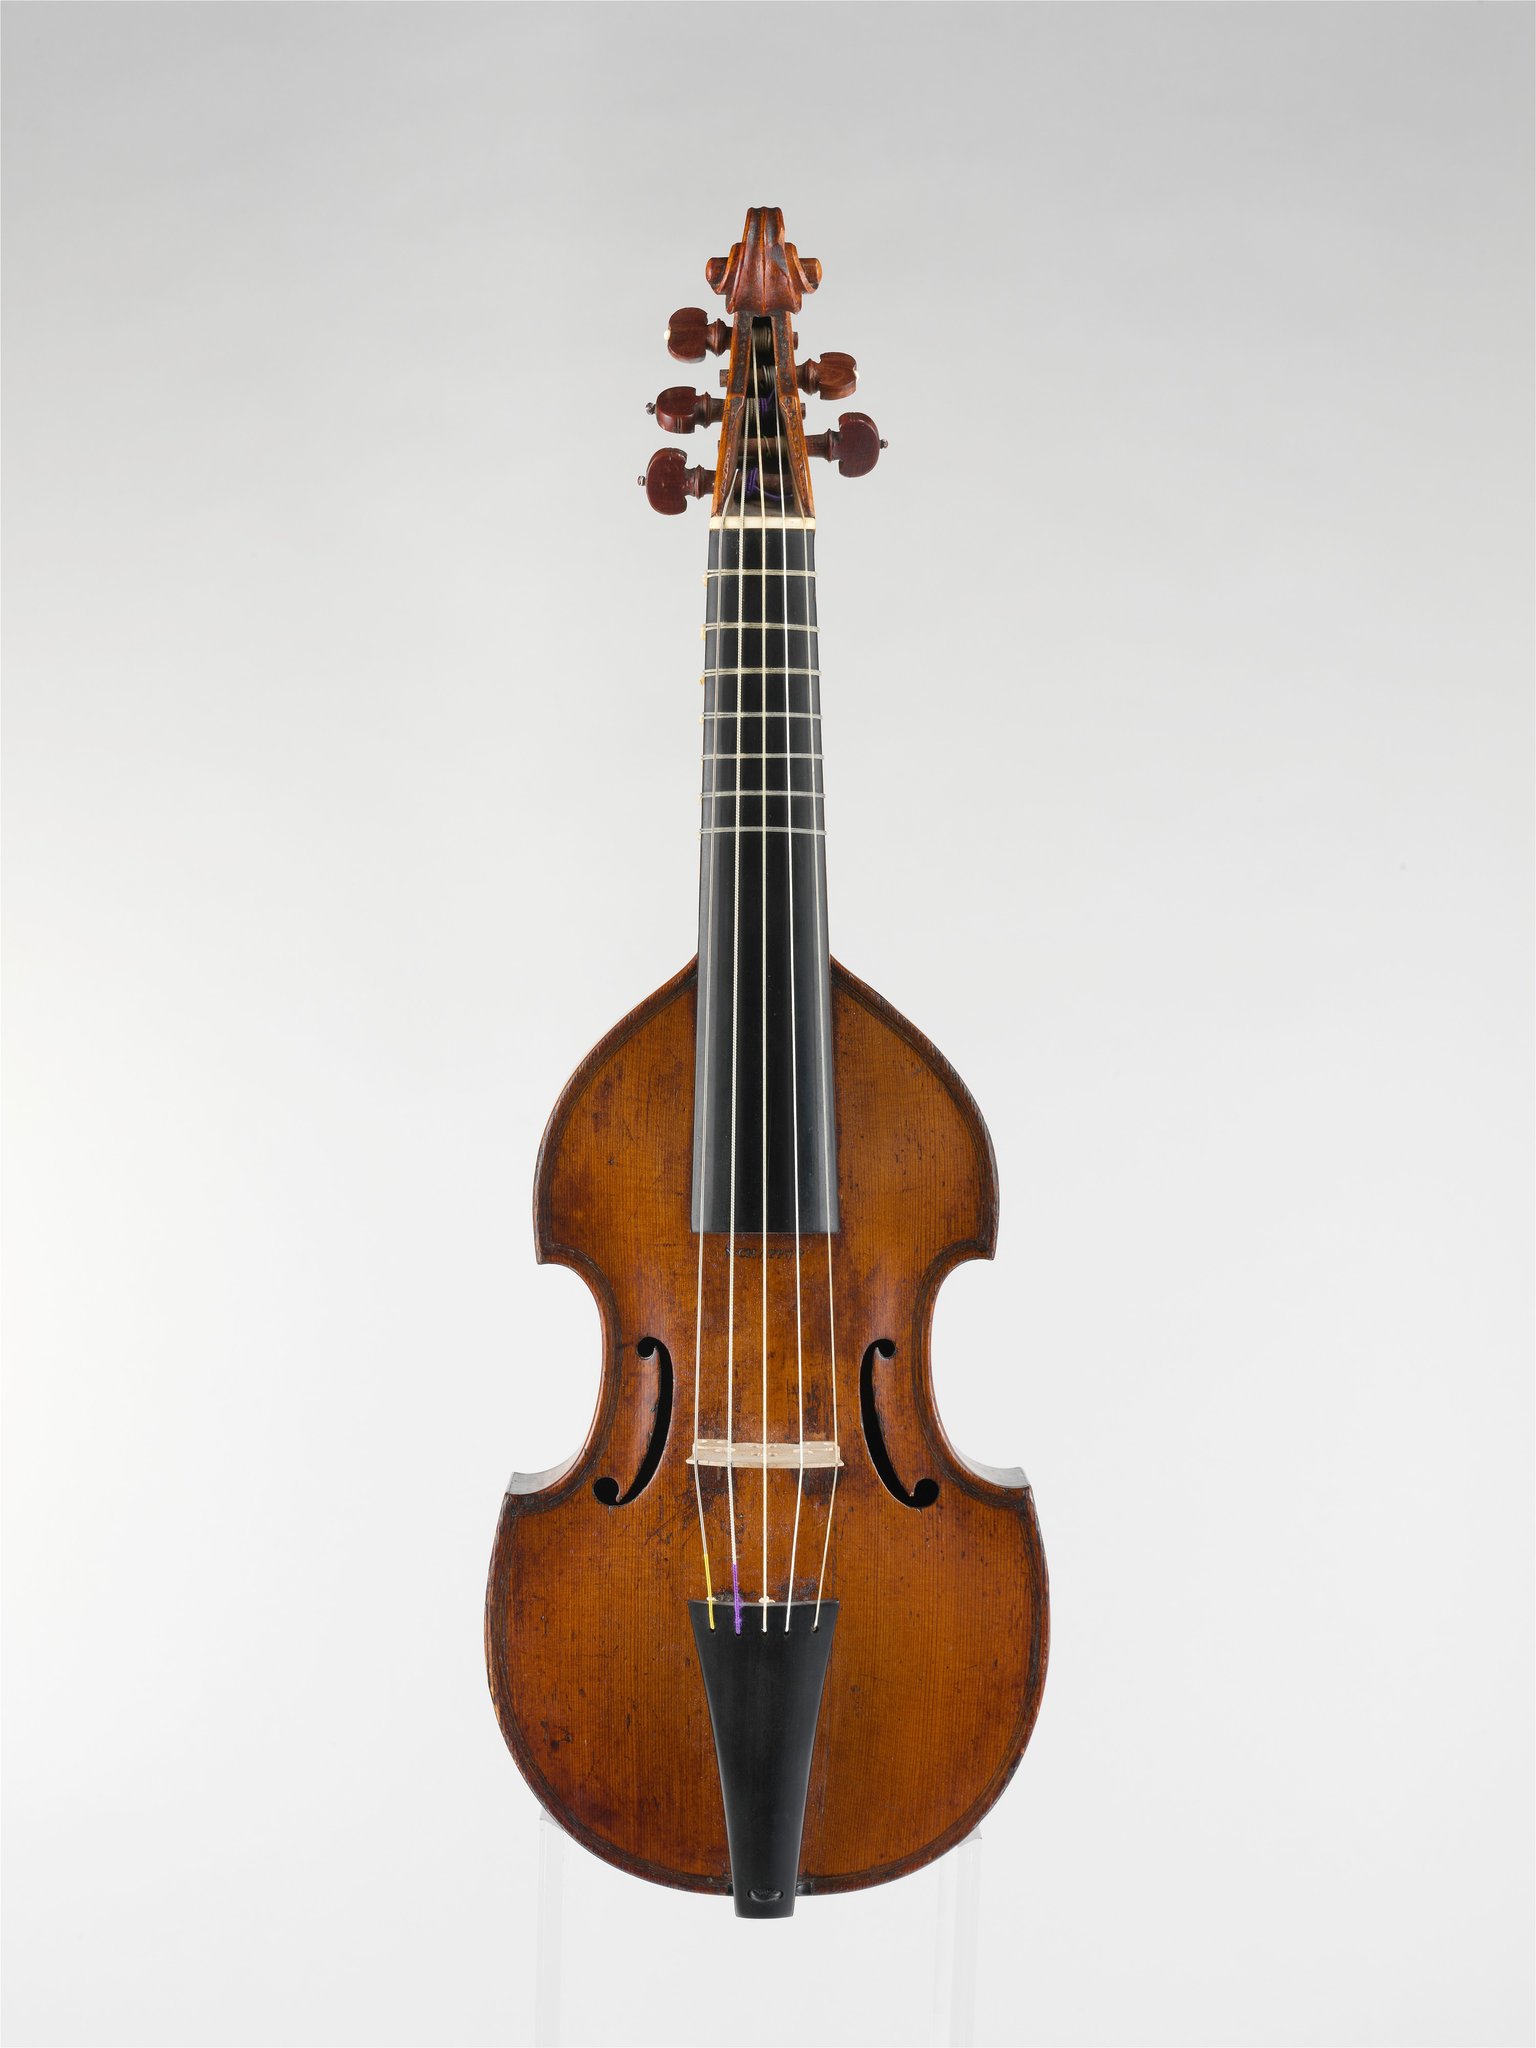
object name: pardessus de viole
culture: french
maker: nicholas chappuy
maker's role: maker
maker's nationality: french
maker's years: 1730-1781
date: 1750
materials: wood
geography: france